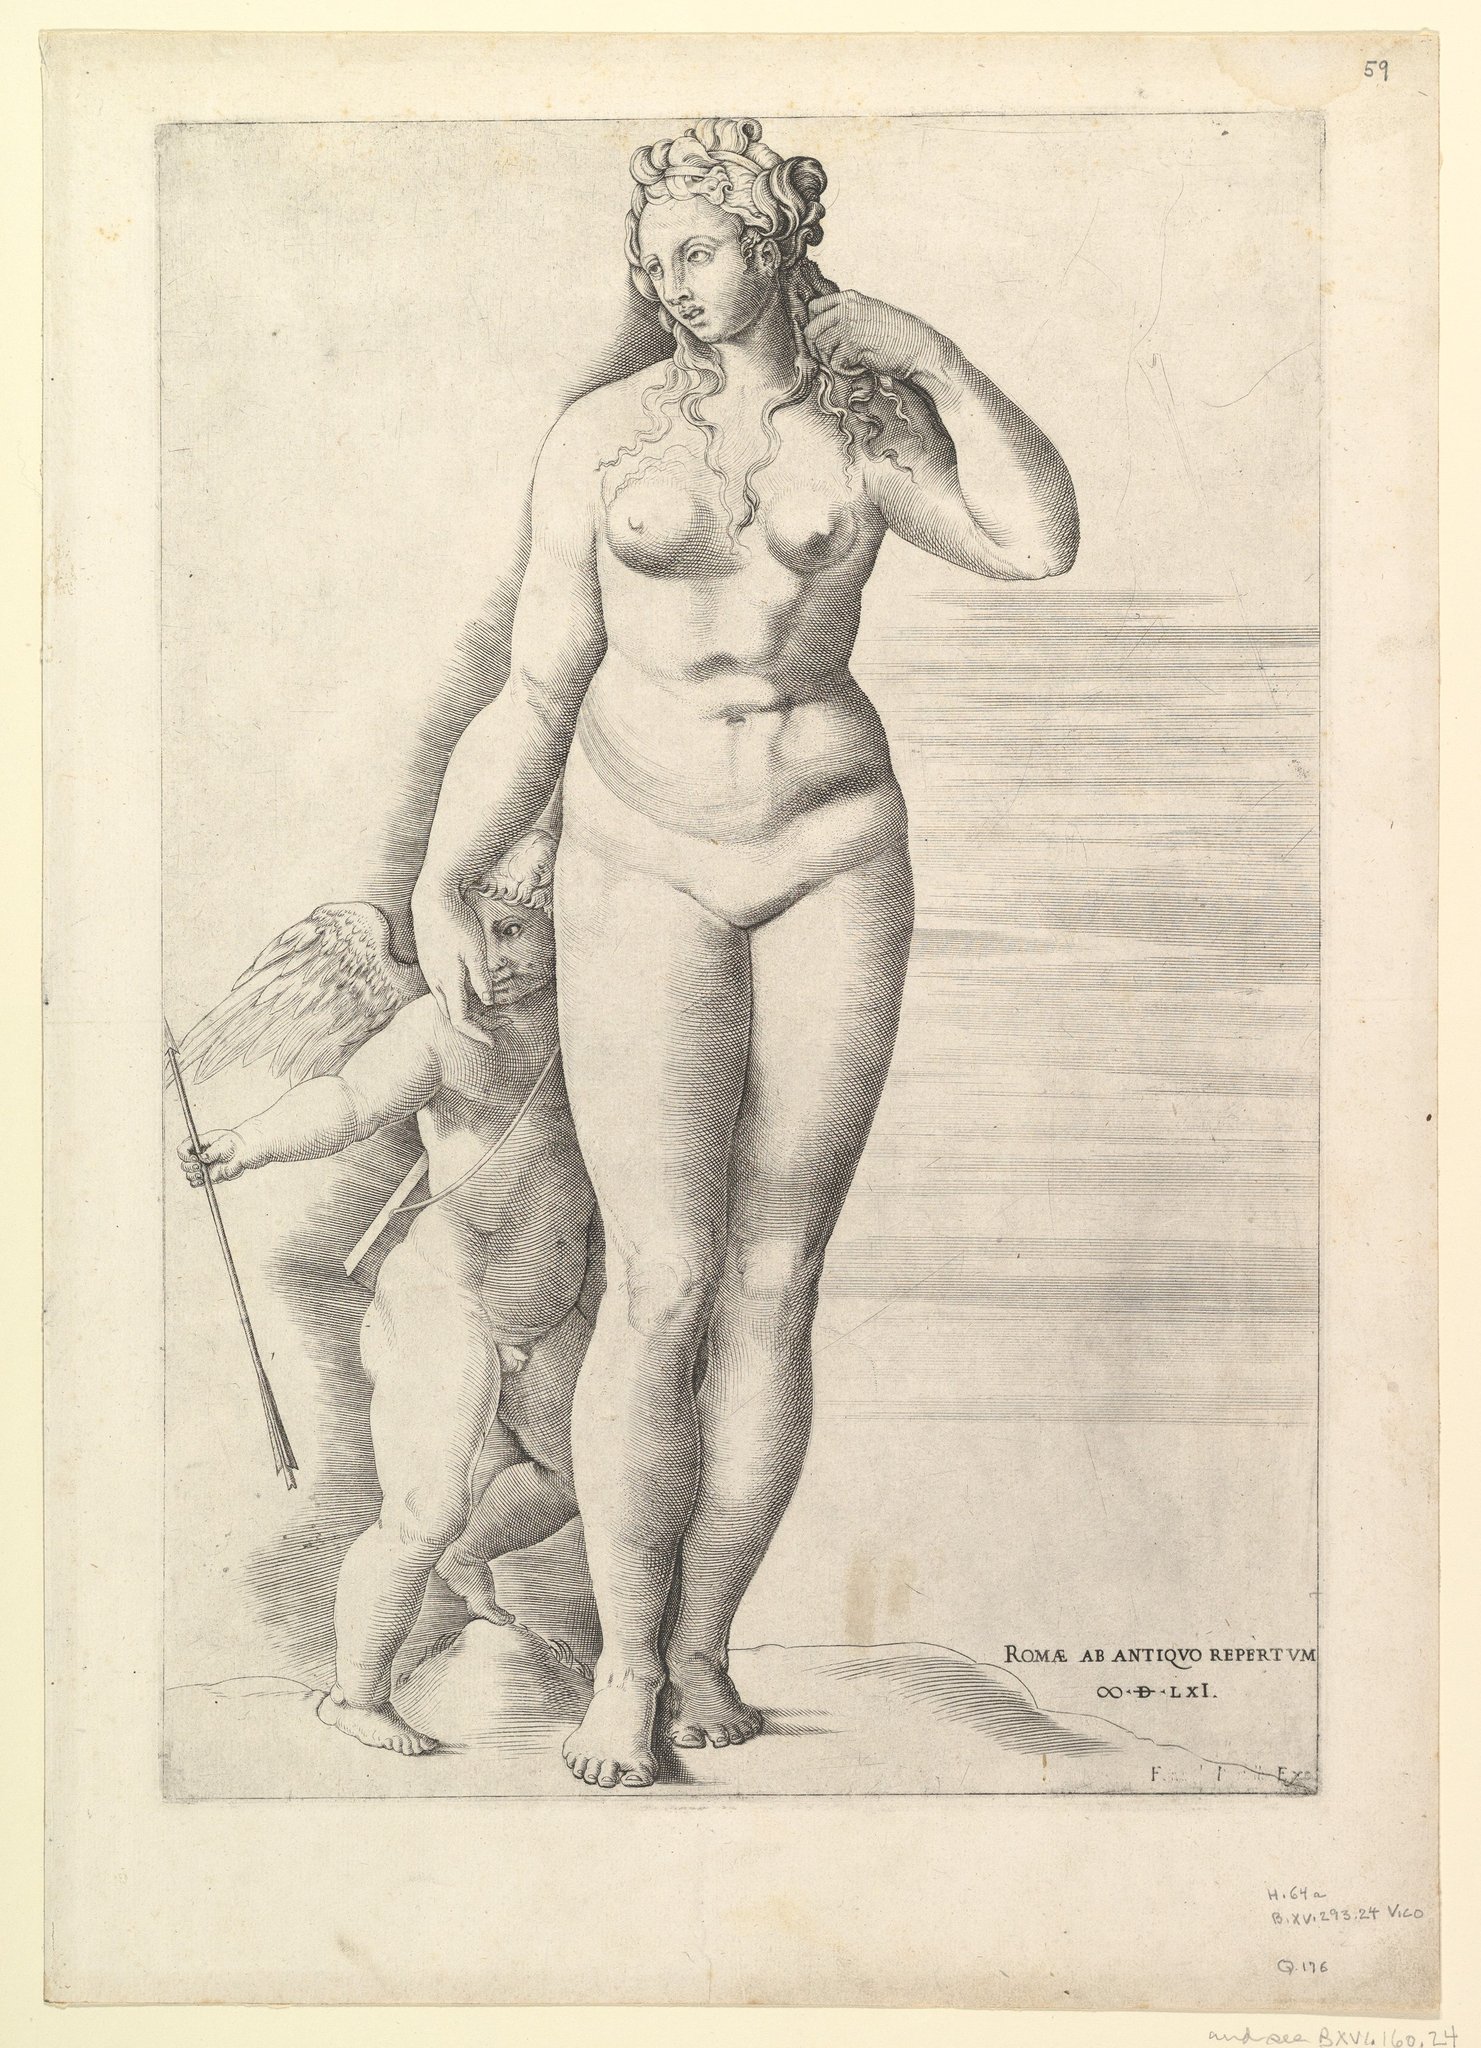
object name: print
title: Venus and Eros, from "Speculum Romanae Magnificentiae"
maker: anonymous, italian, 16th century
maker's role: artist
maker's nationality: italian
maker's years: 1500-1600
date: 1561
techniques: engraving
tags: eros,venus